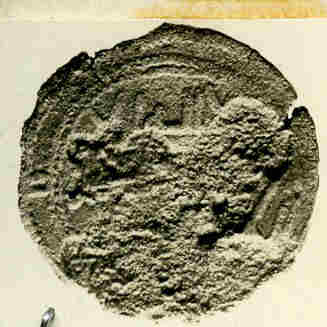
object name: coin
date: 767-800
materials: copper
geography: iran